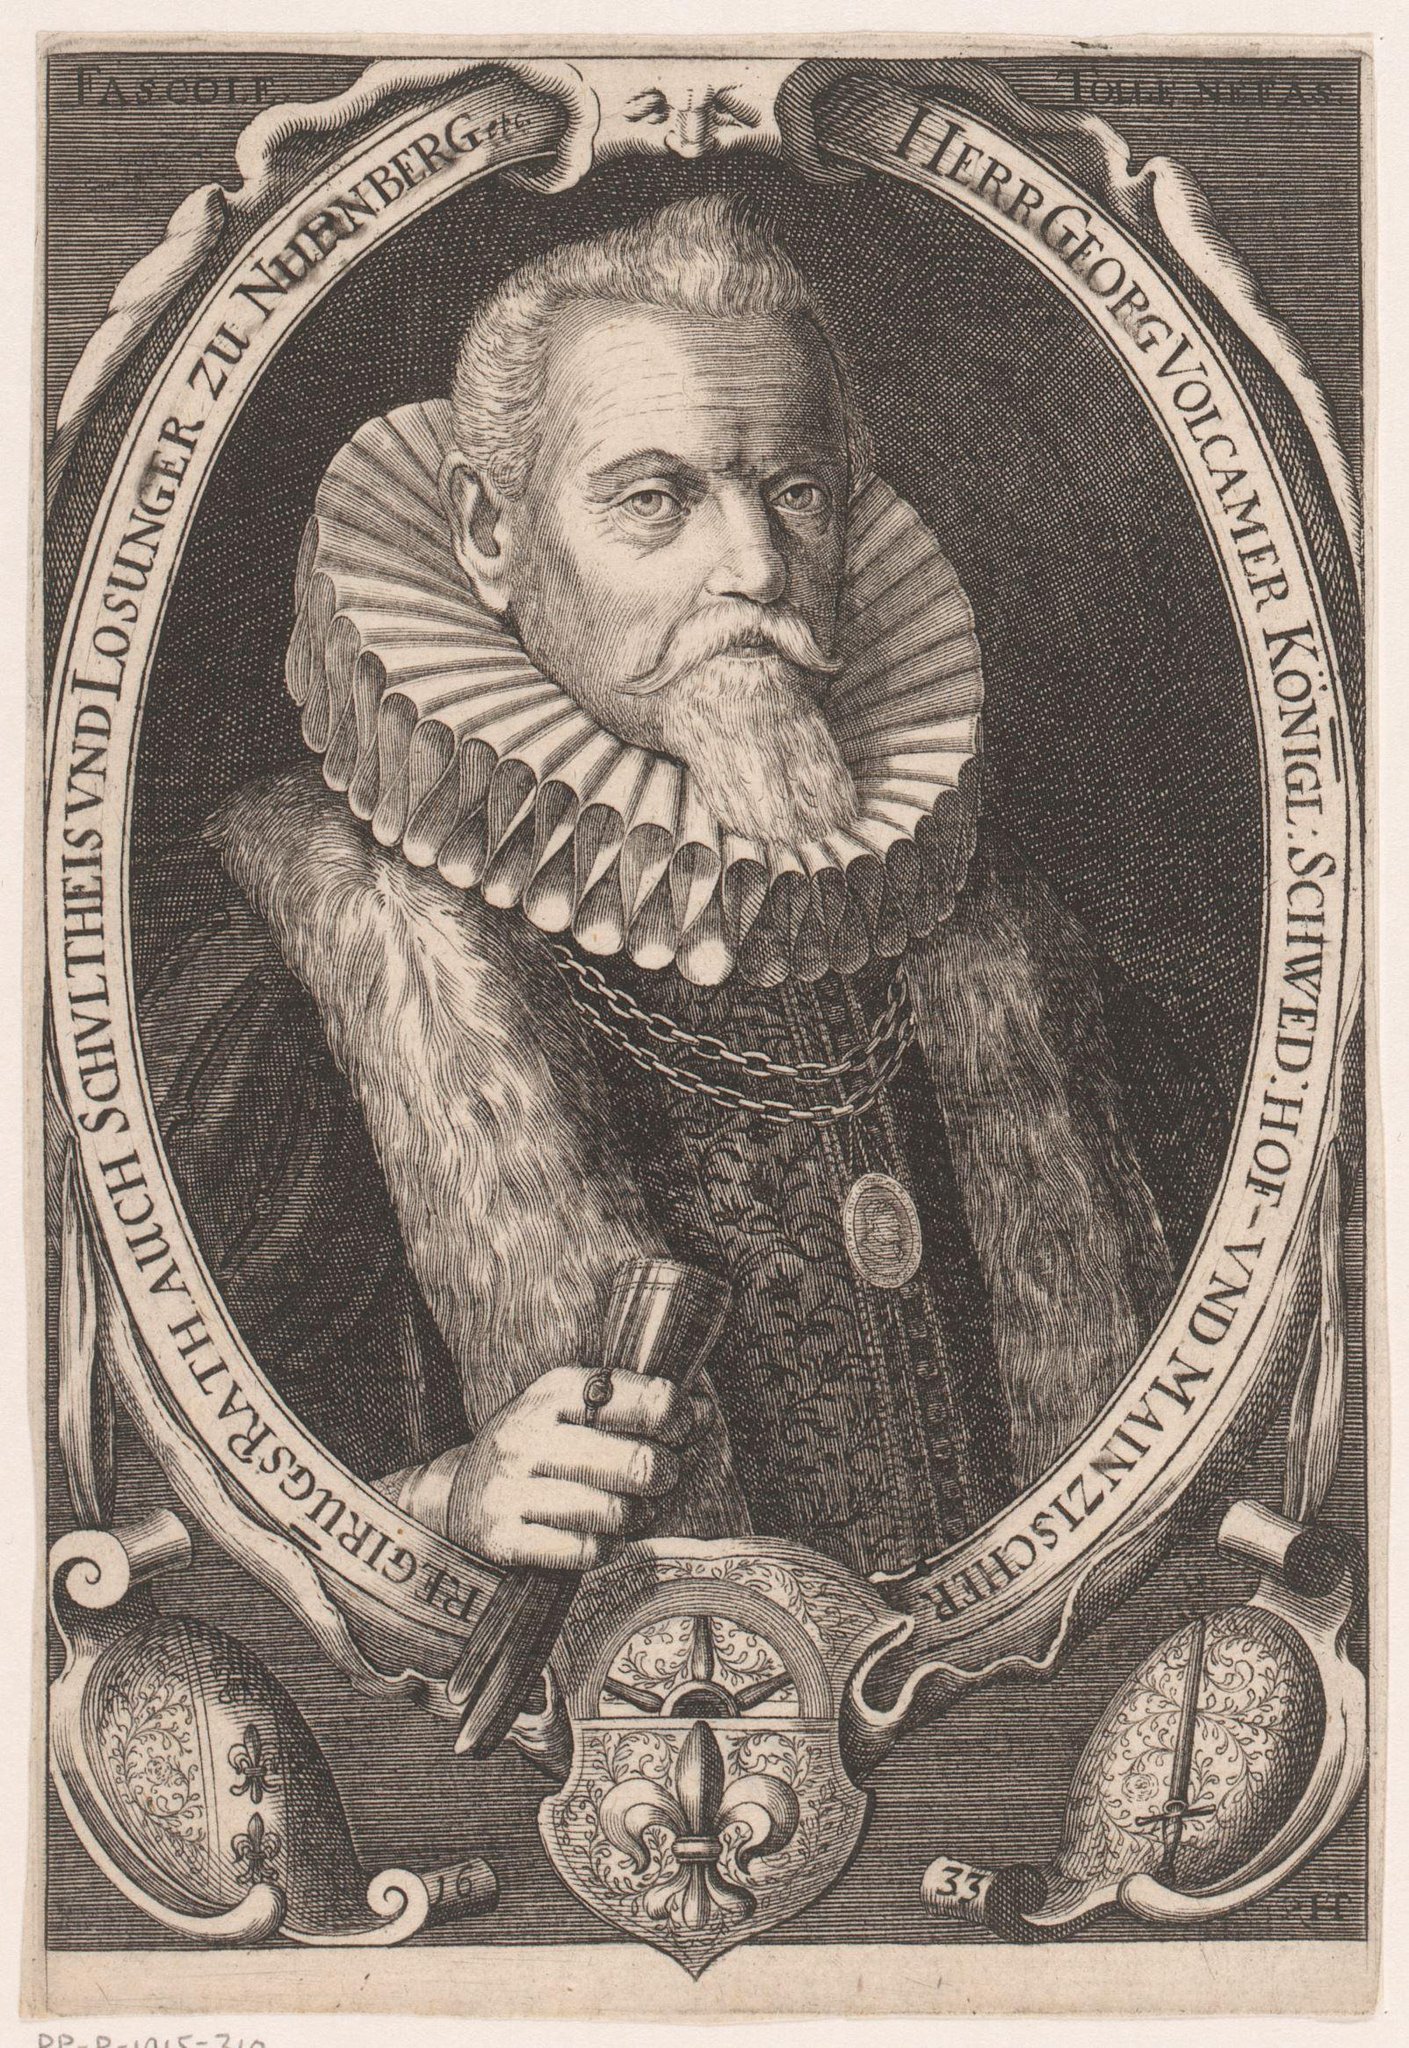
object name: print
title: Portret van Georg Volckamer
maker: hans troschel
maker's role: draughtsman, print maker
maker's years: 1585-1628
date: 1595-1633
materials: paper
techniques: engraving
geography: germany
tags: mayor, anthropomorphic ornament, gloves, mittens, etc., historical persons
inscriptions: collector's mark: Lugt 2228